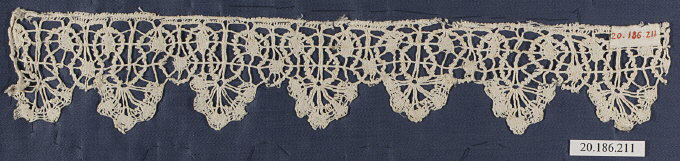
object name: edging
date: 1601-1700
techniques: lace